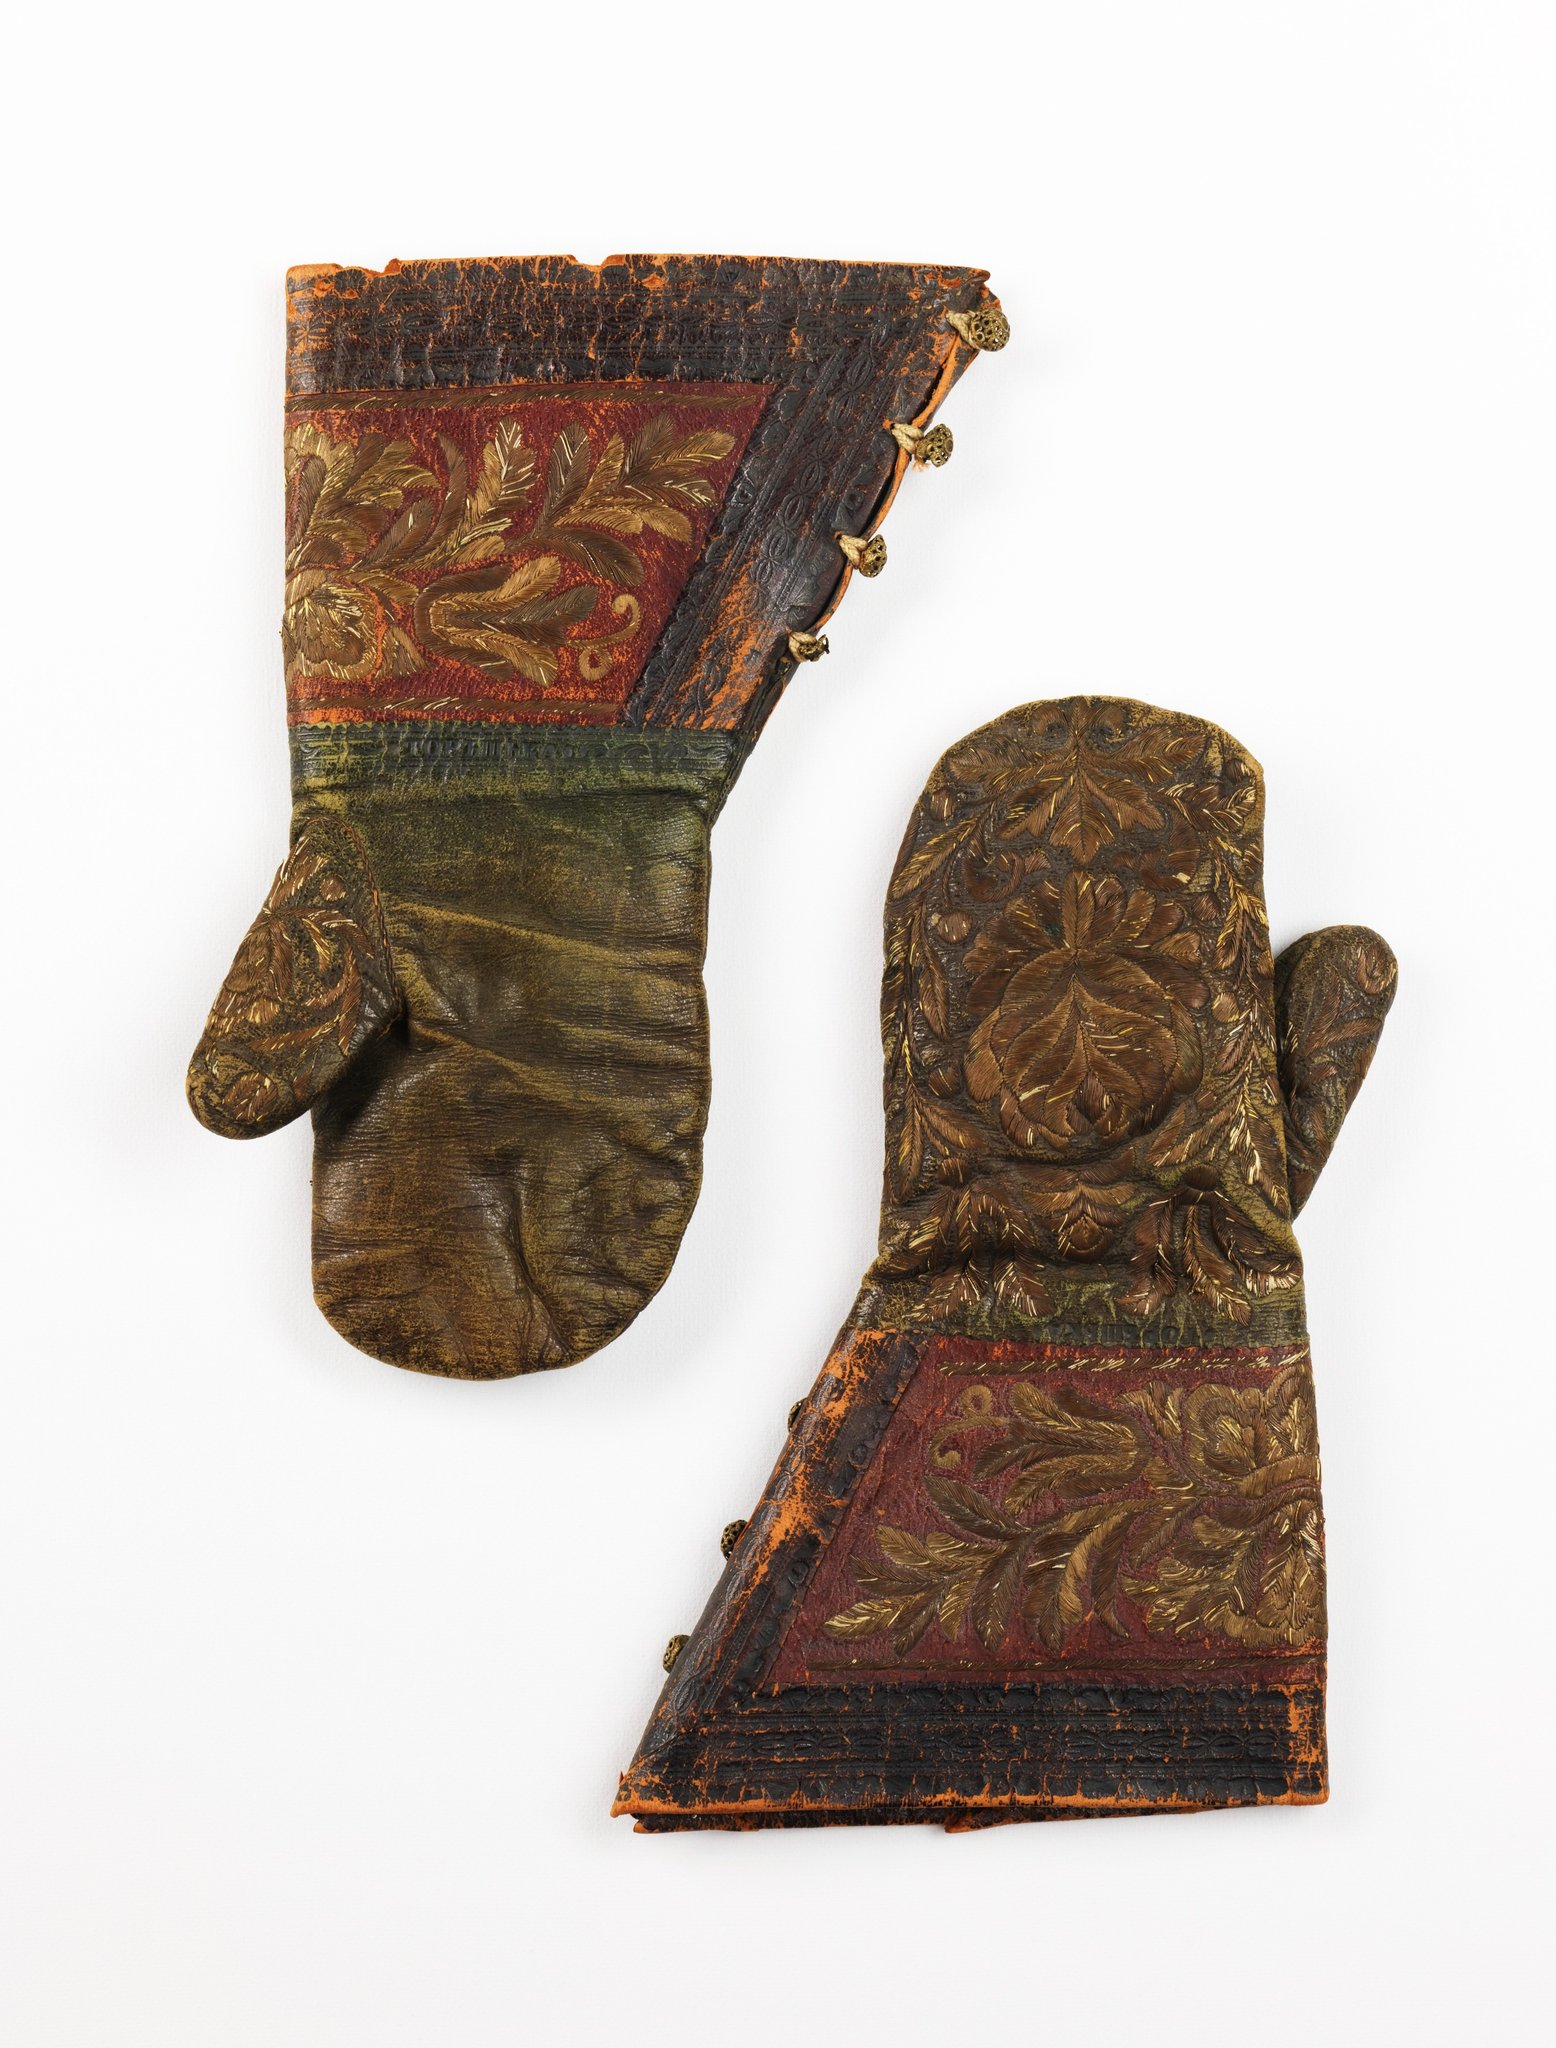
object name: mitten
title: Mittens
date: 1667-1700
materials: leather, metal, silk